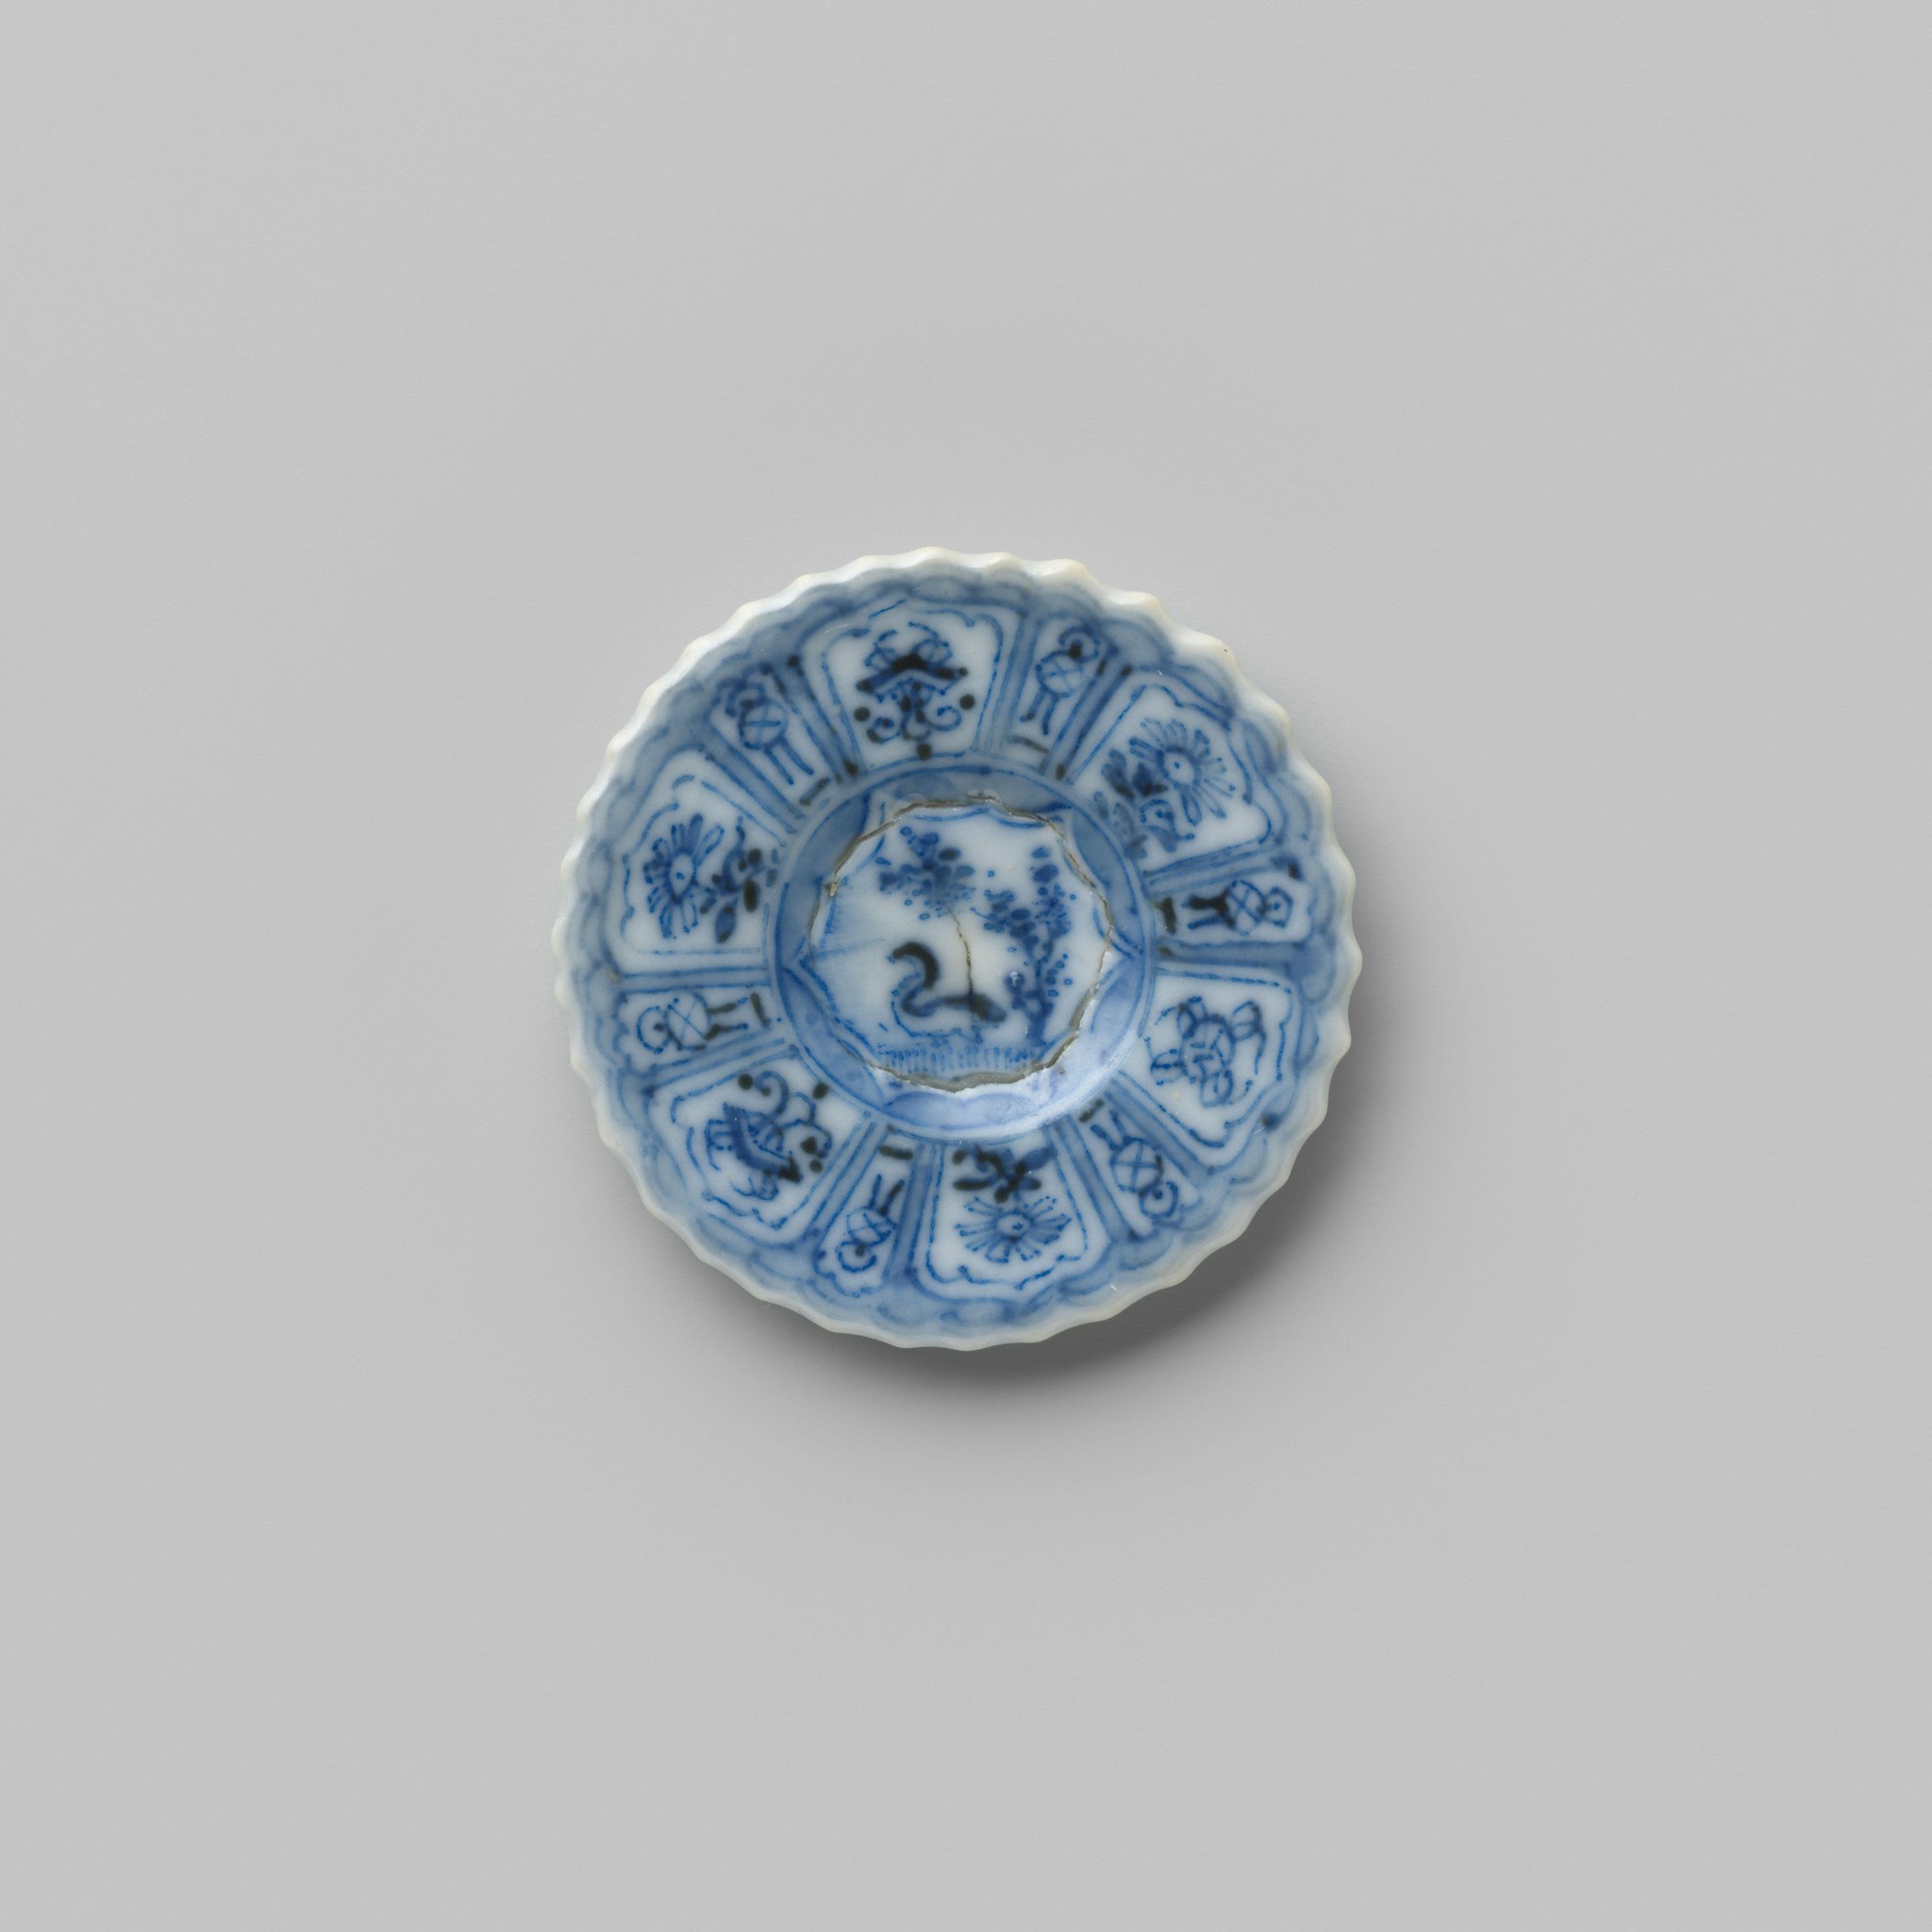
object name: miniature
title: Plate with a bird in a landscape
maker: Anonymous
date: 1690-1710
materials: cobalt, glaze, paint, porcelain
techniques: firing, turning, vitrification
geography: china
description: Eén van 12 borden van porselein en steatite met blauwe onderglazuur, decoratie in 'Kraakporselein' of Wanli stijl: plat met vogel (eend) onder boom aan oever, rand in vakken met strikwerk, bloemen en symbolen, geribbelde rand. Bordje eveneens op achterzijde versierd, rand in vakken met bloemen.